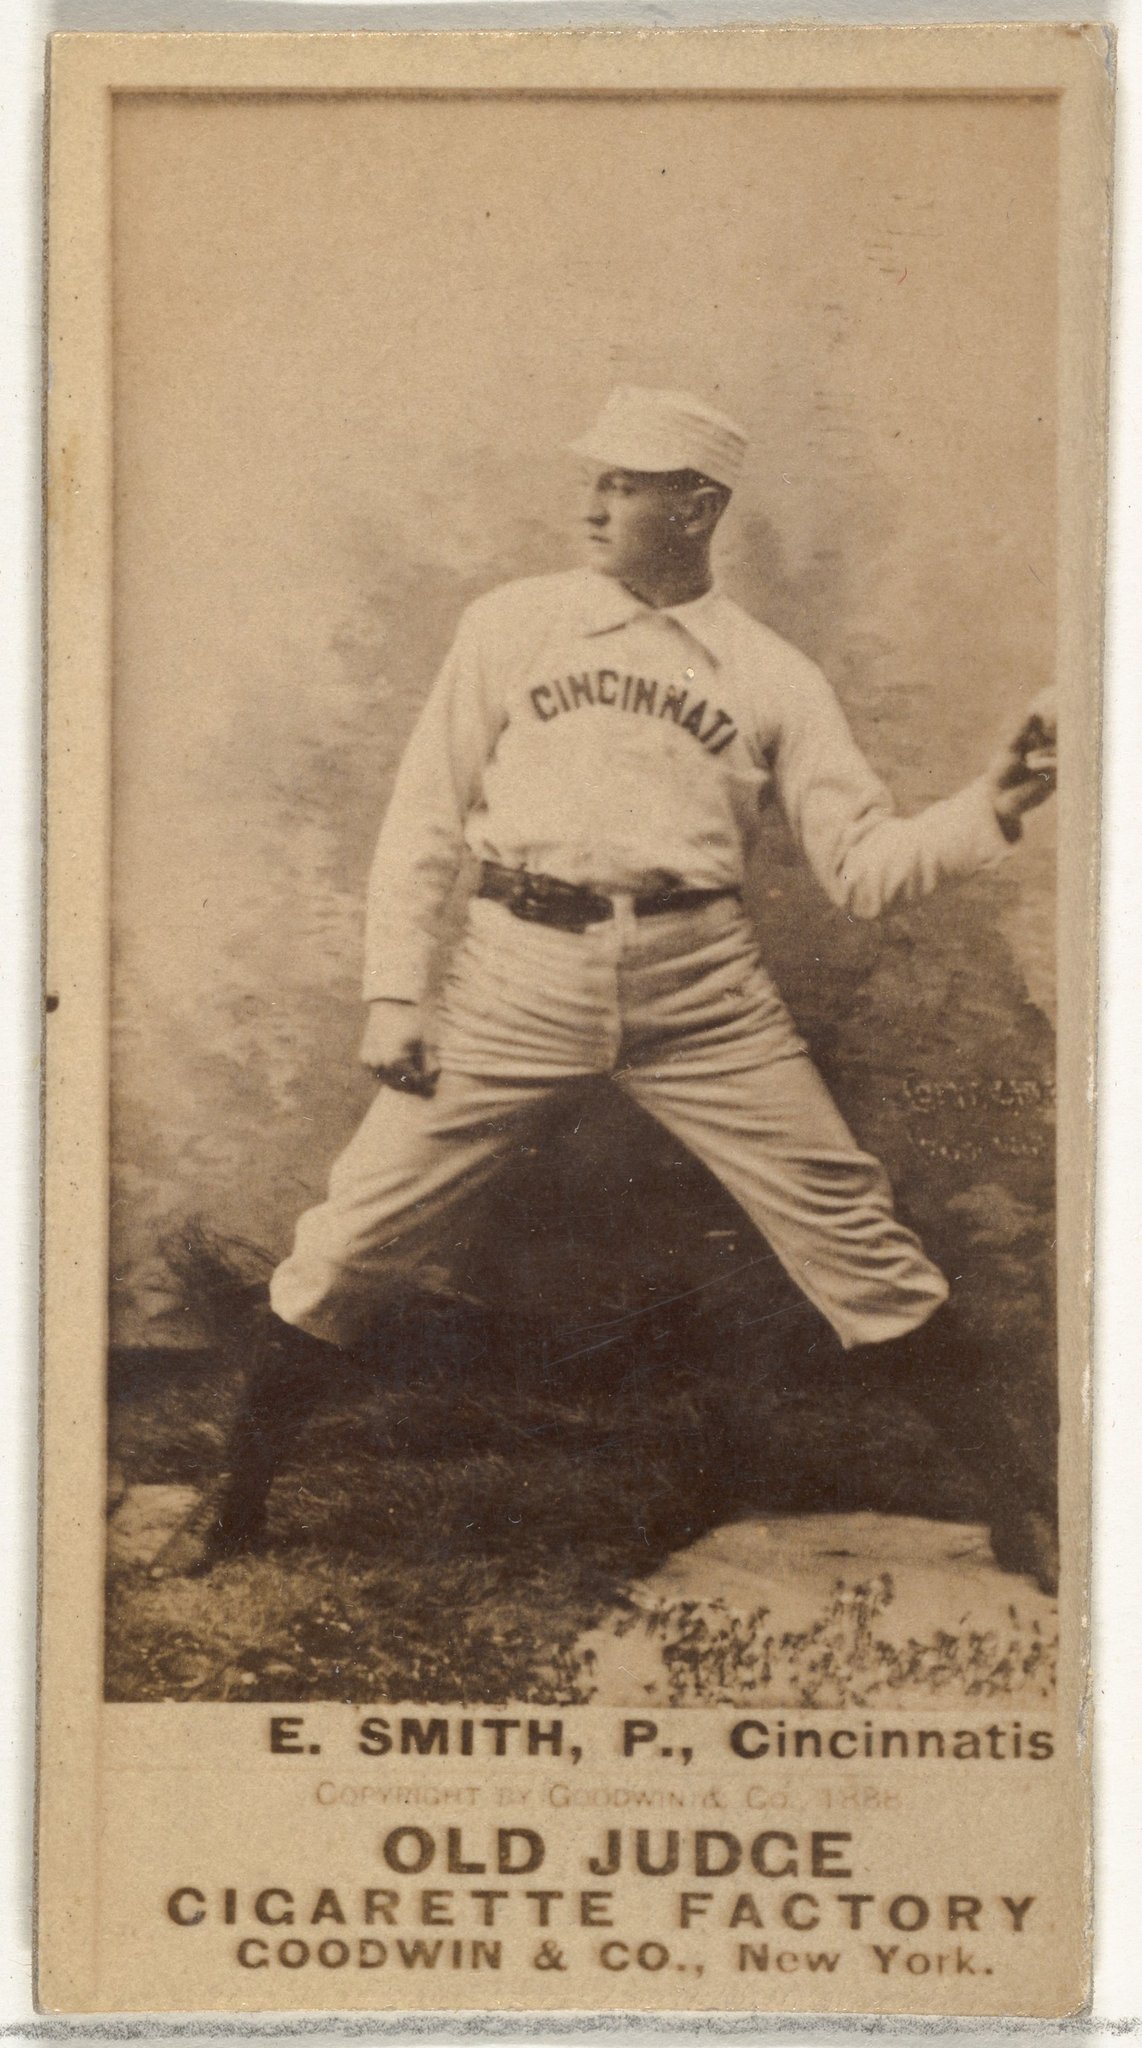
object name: baseball card, photograph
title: Elmer Ellsworth "Mike" Smith, Pitcher, Cincinnati, from the Old Judge series (N172) for Old Judge Cigarettes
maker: goodwin & company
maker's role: publisher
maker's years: 1850-1950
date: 1888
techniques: albumen silver print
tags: men,portraits,baseball,athletes